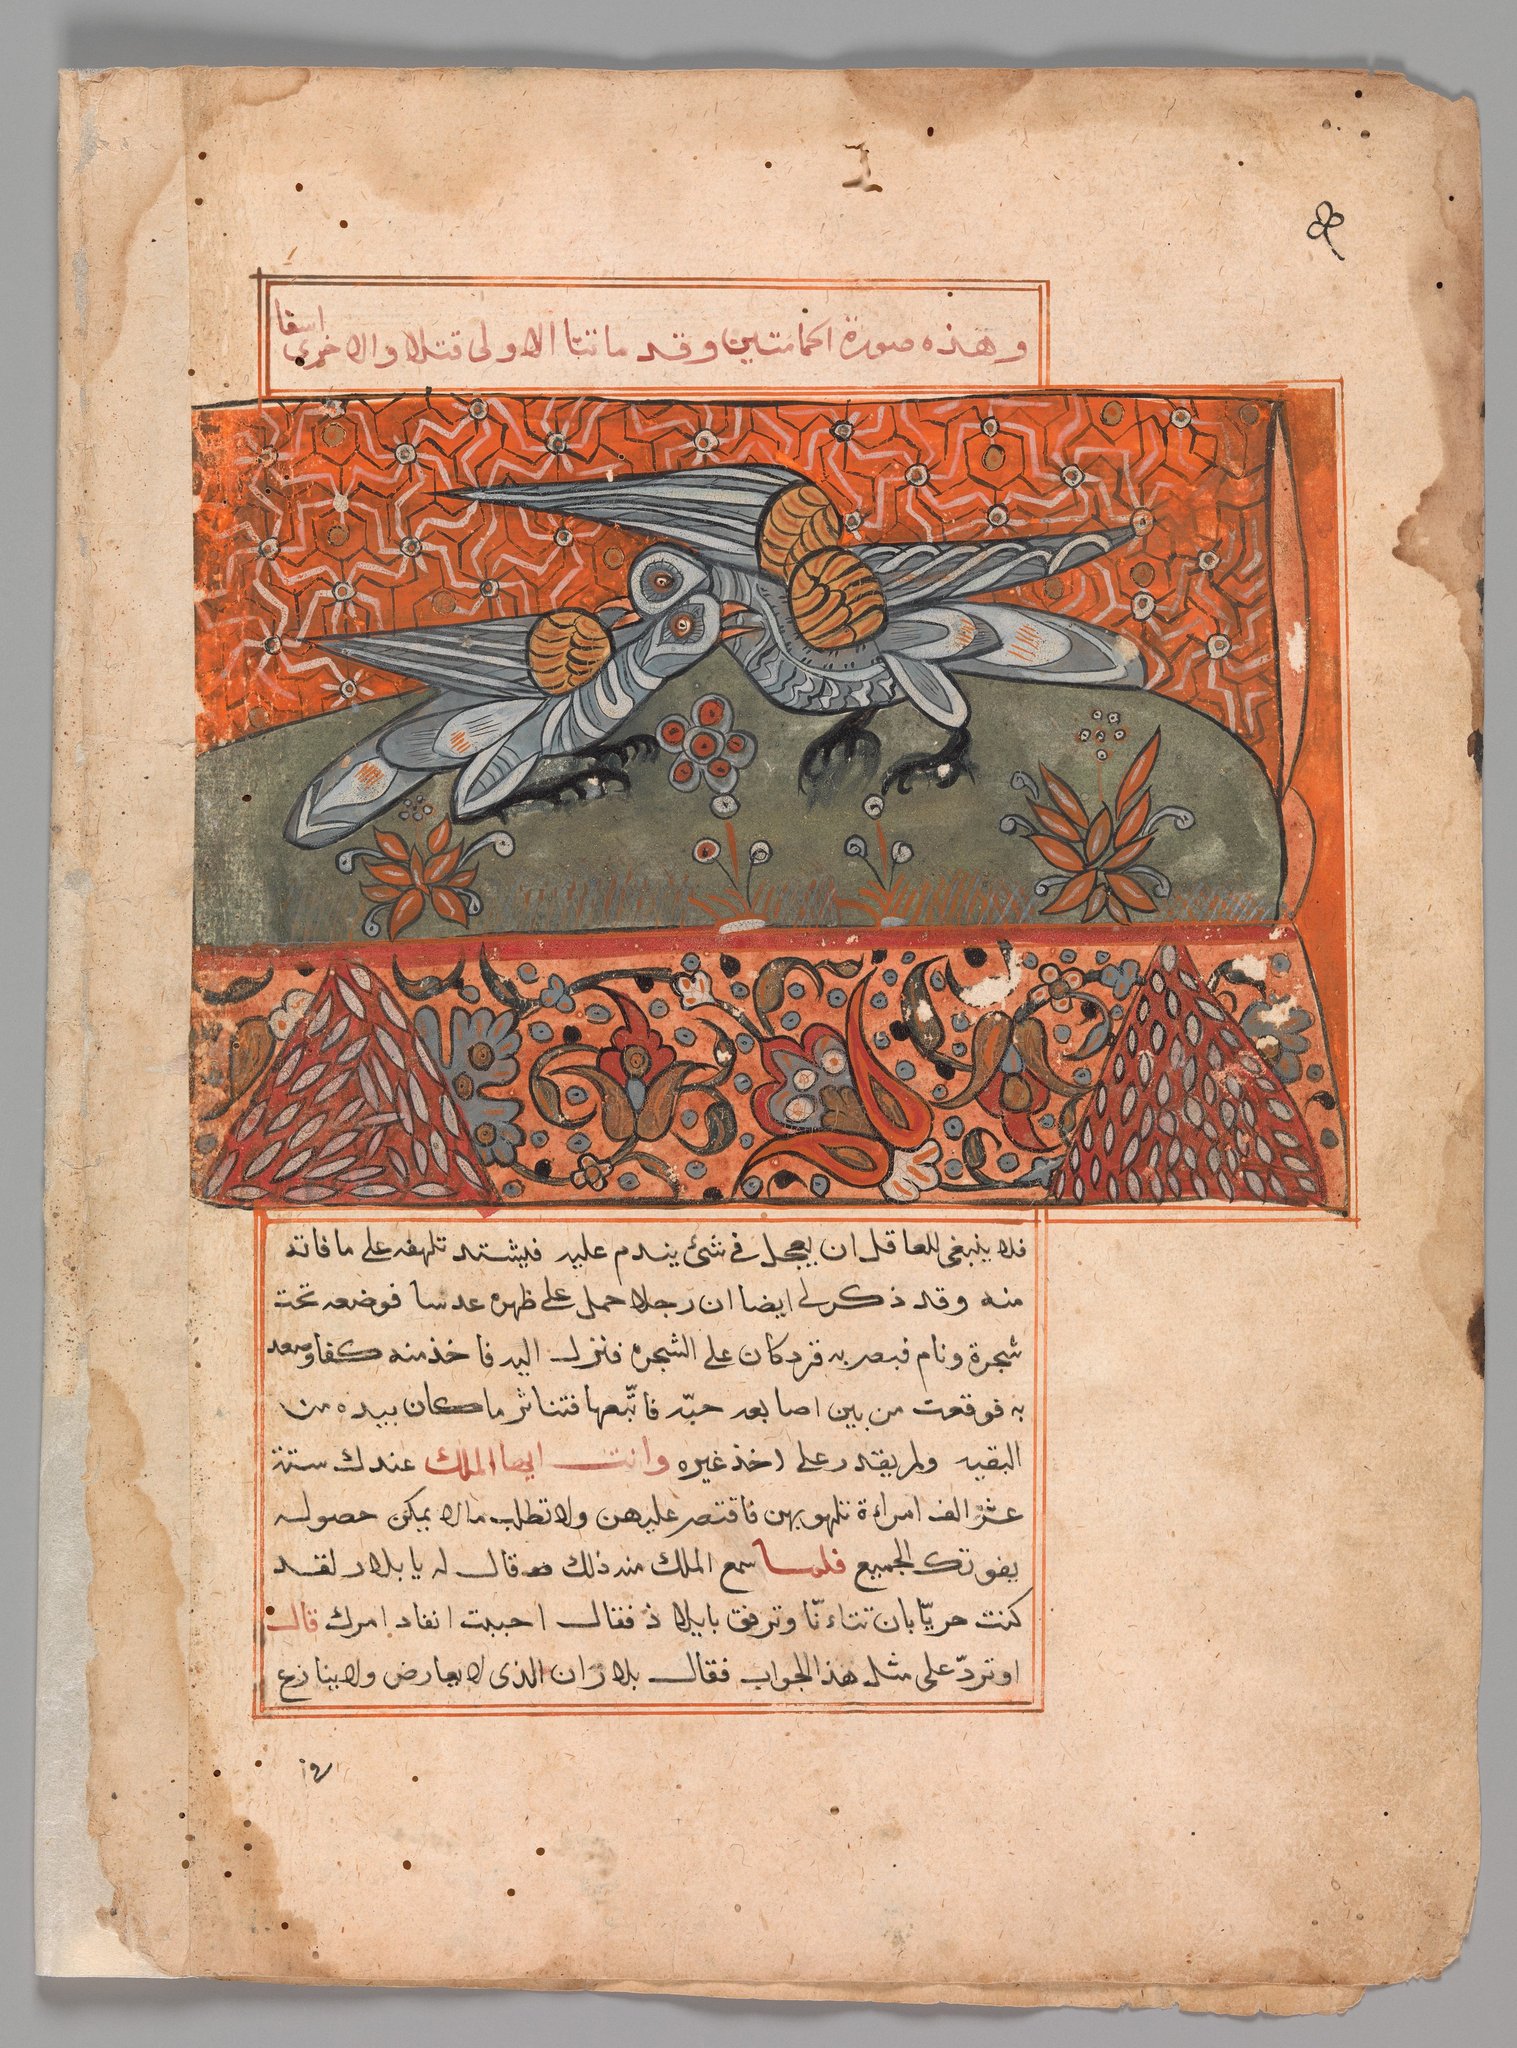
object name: folio from an illustrated manuscript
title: "The Male Dove Pecking the Female Dove", Folio from a Kalila wa Dimna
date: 1526-1550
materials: ink, paper, watercolor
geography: india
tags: doves